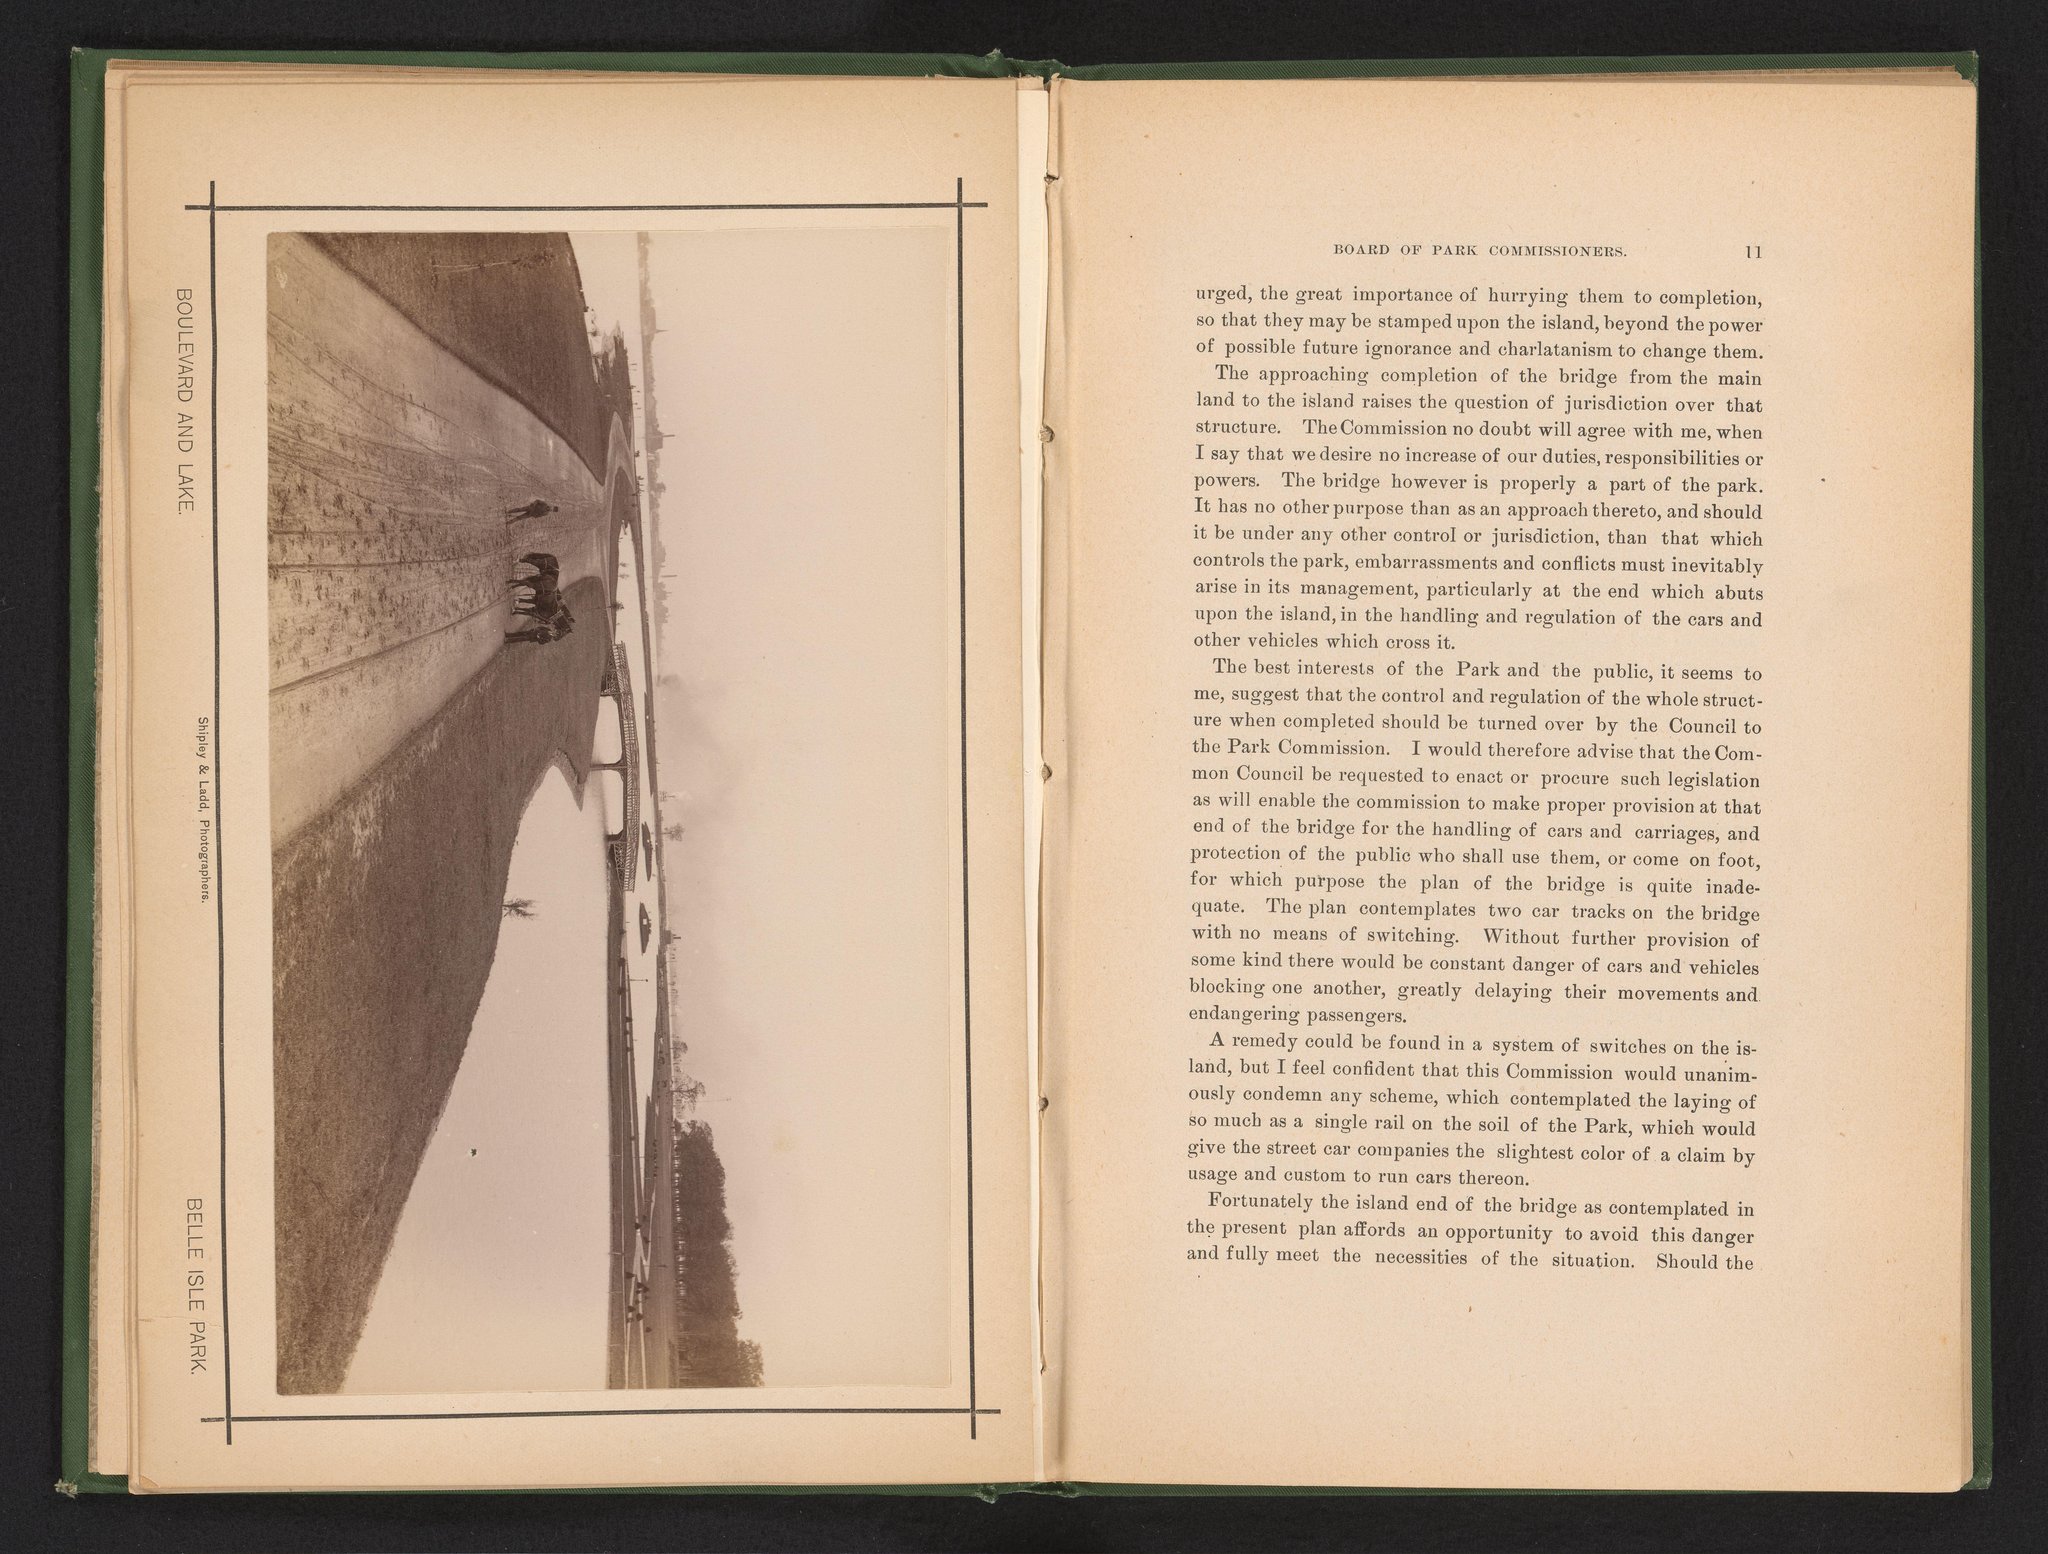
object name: page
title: Boulevard and Lake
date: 1879-1889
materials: photographic support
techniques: albumen print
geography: belle isle park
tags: canal, lake, avenue, boulevard, promenade, esplanade, bridge